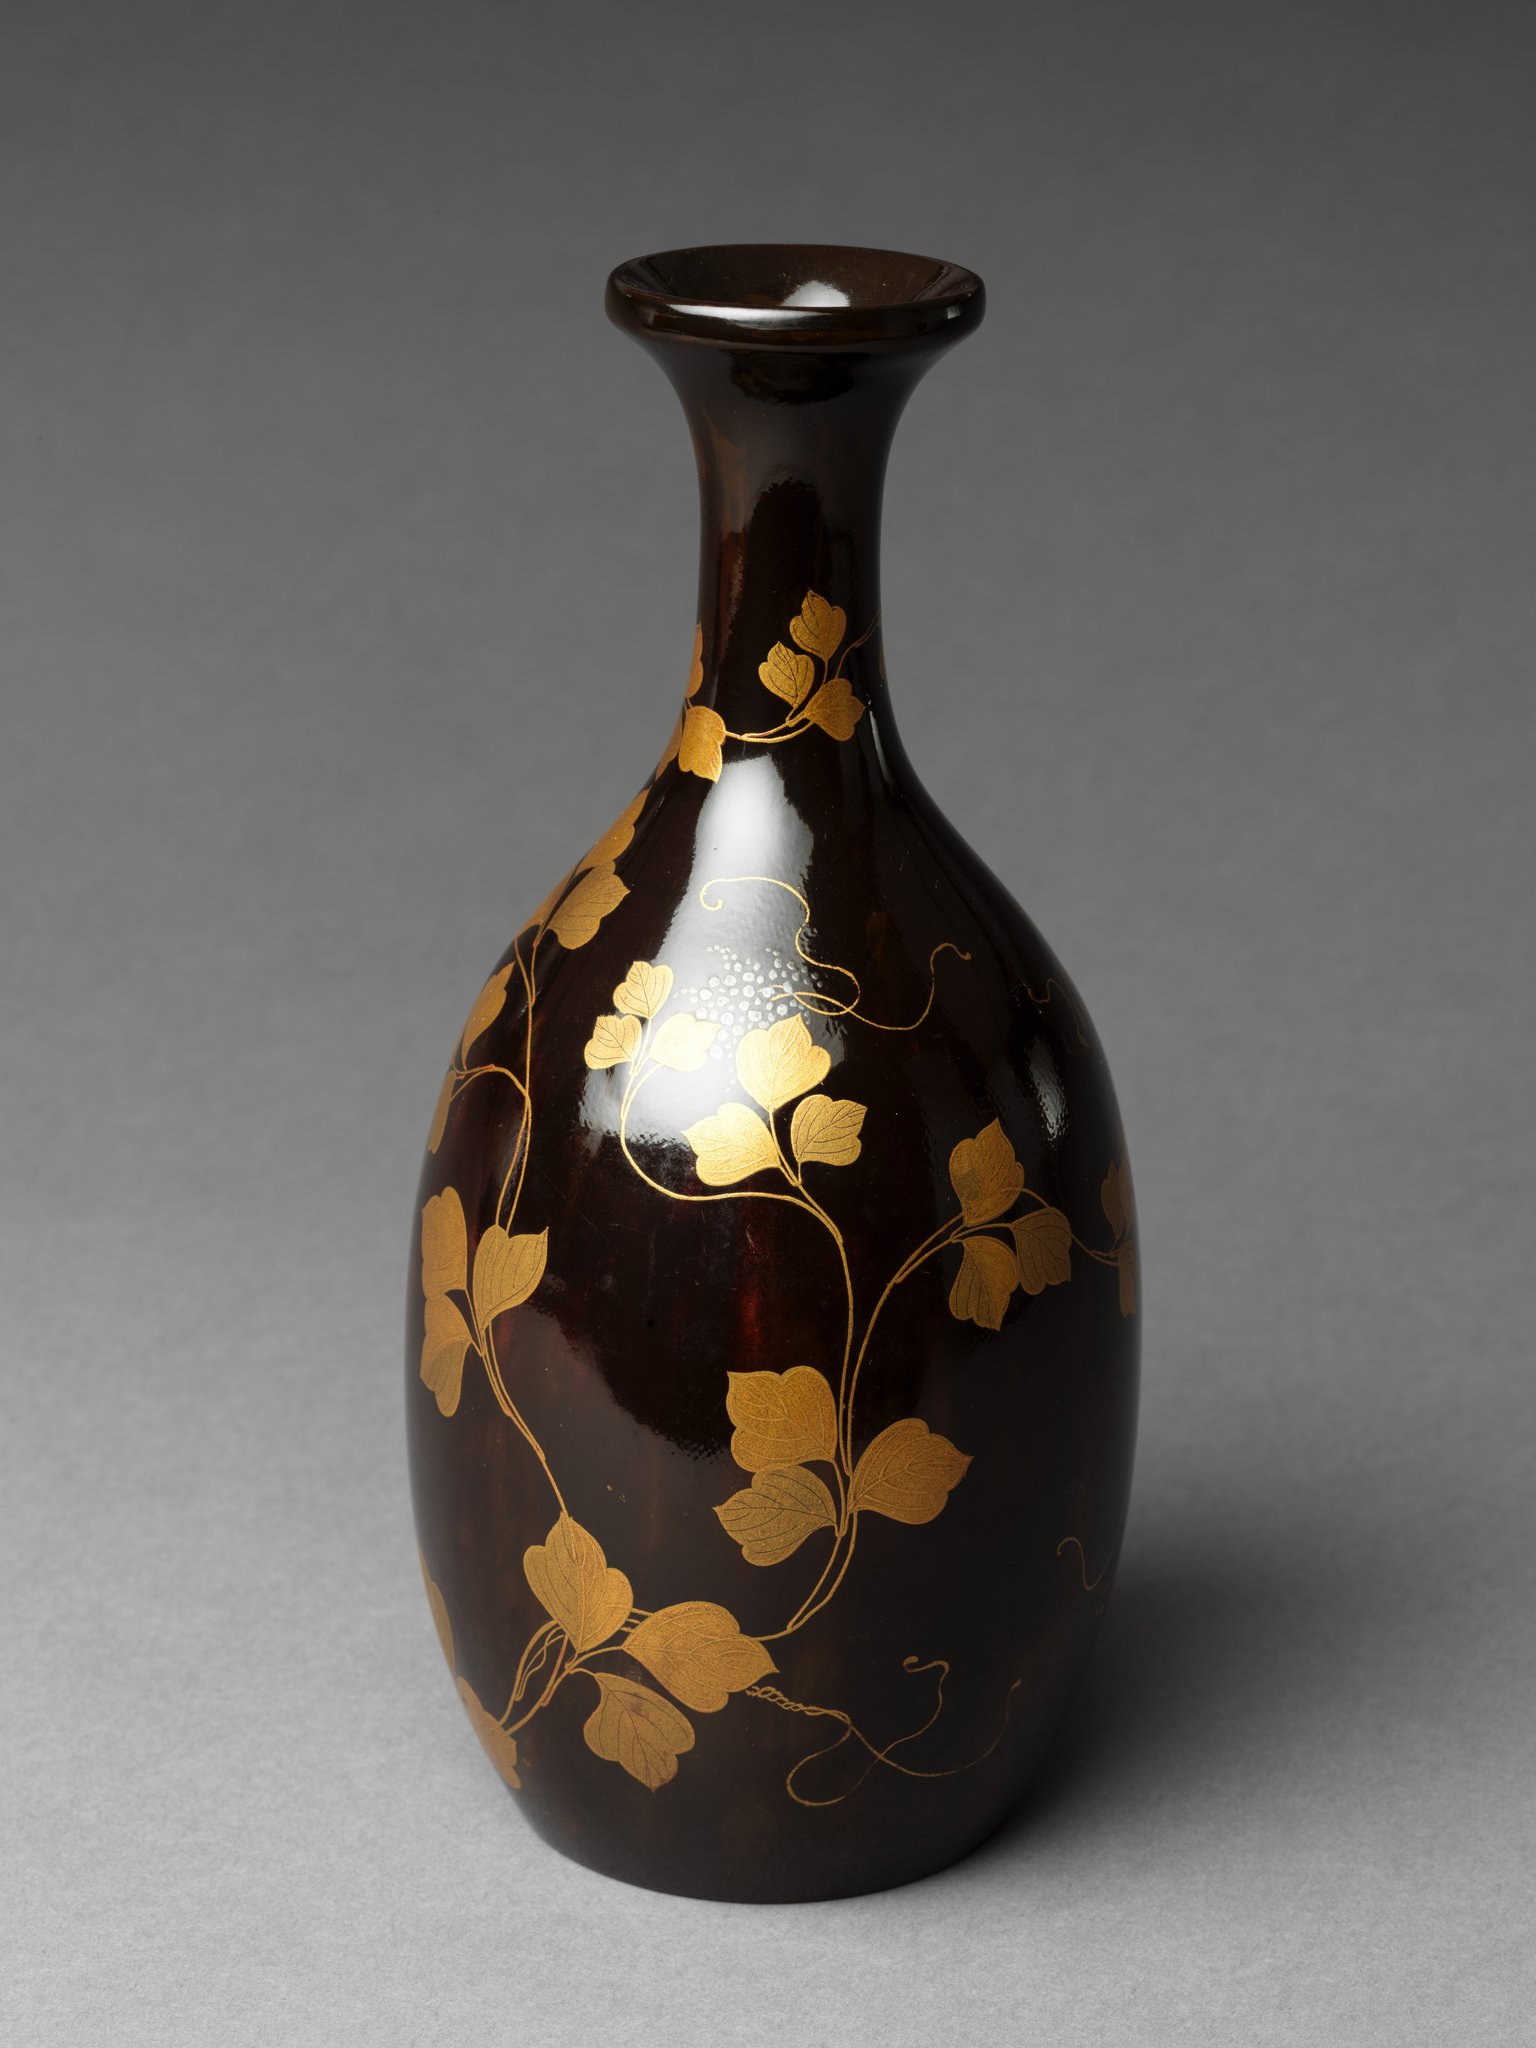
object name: sake bottle one of a pair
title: Sake bottle with grapevine decoration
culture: japanese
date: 1651-1700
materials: gold, lacquer, silver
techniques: maki